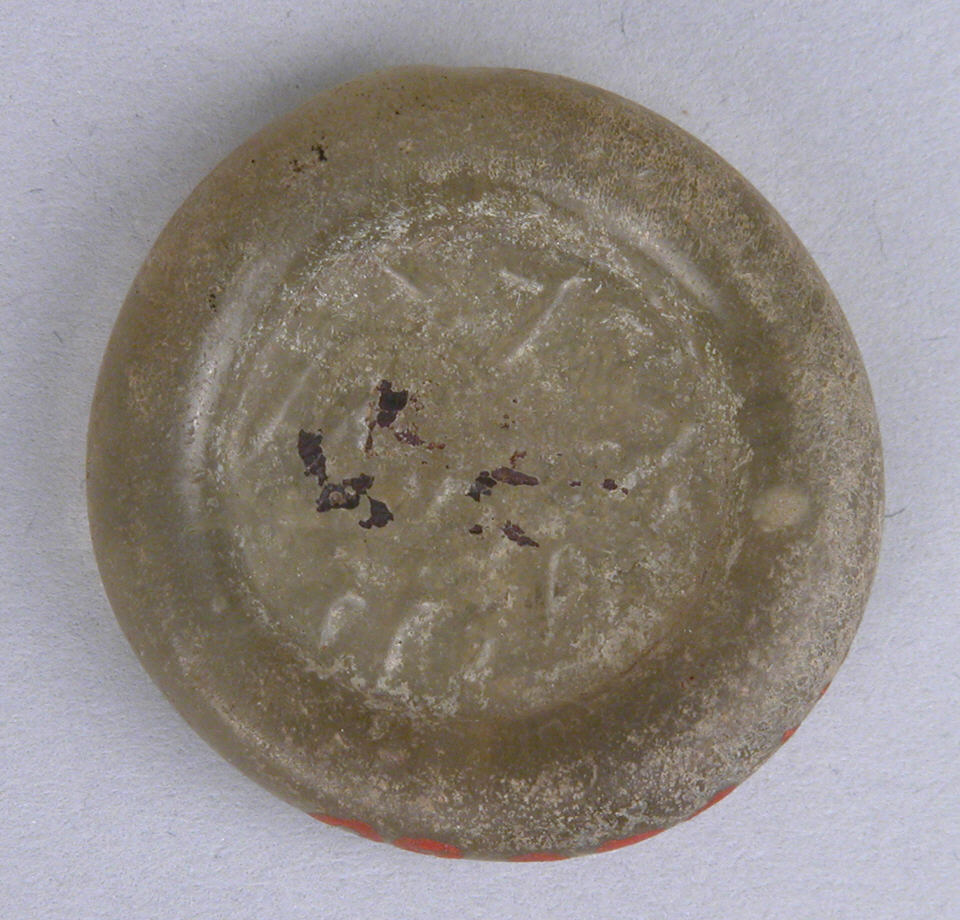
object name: coin weight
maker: muhammad al 'audi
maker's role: maker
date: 1001-1100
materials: glass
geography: egypt